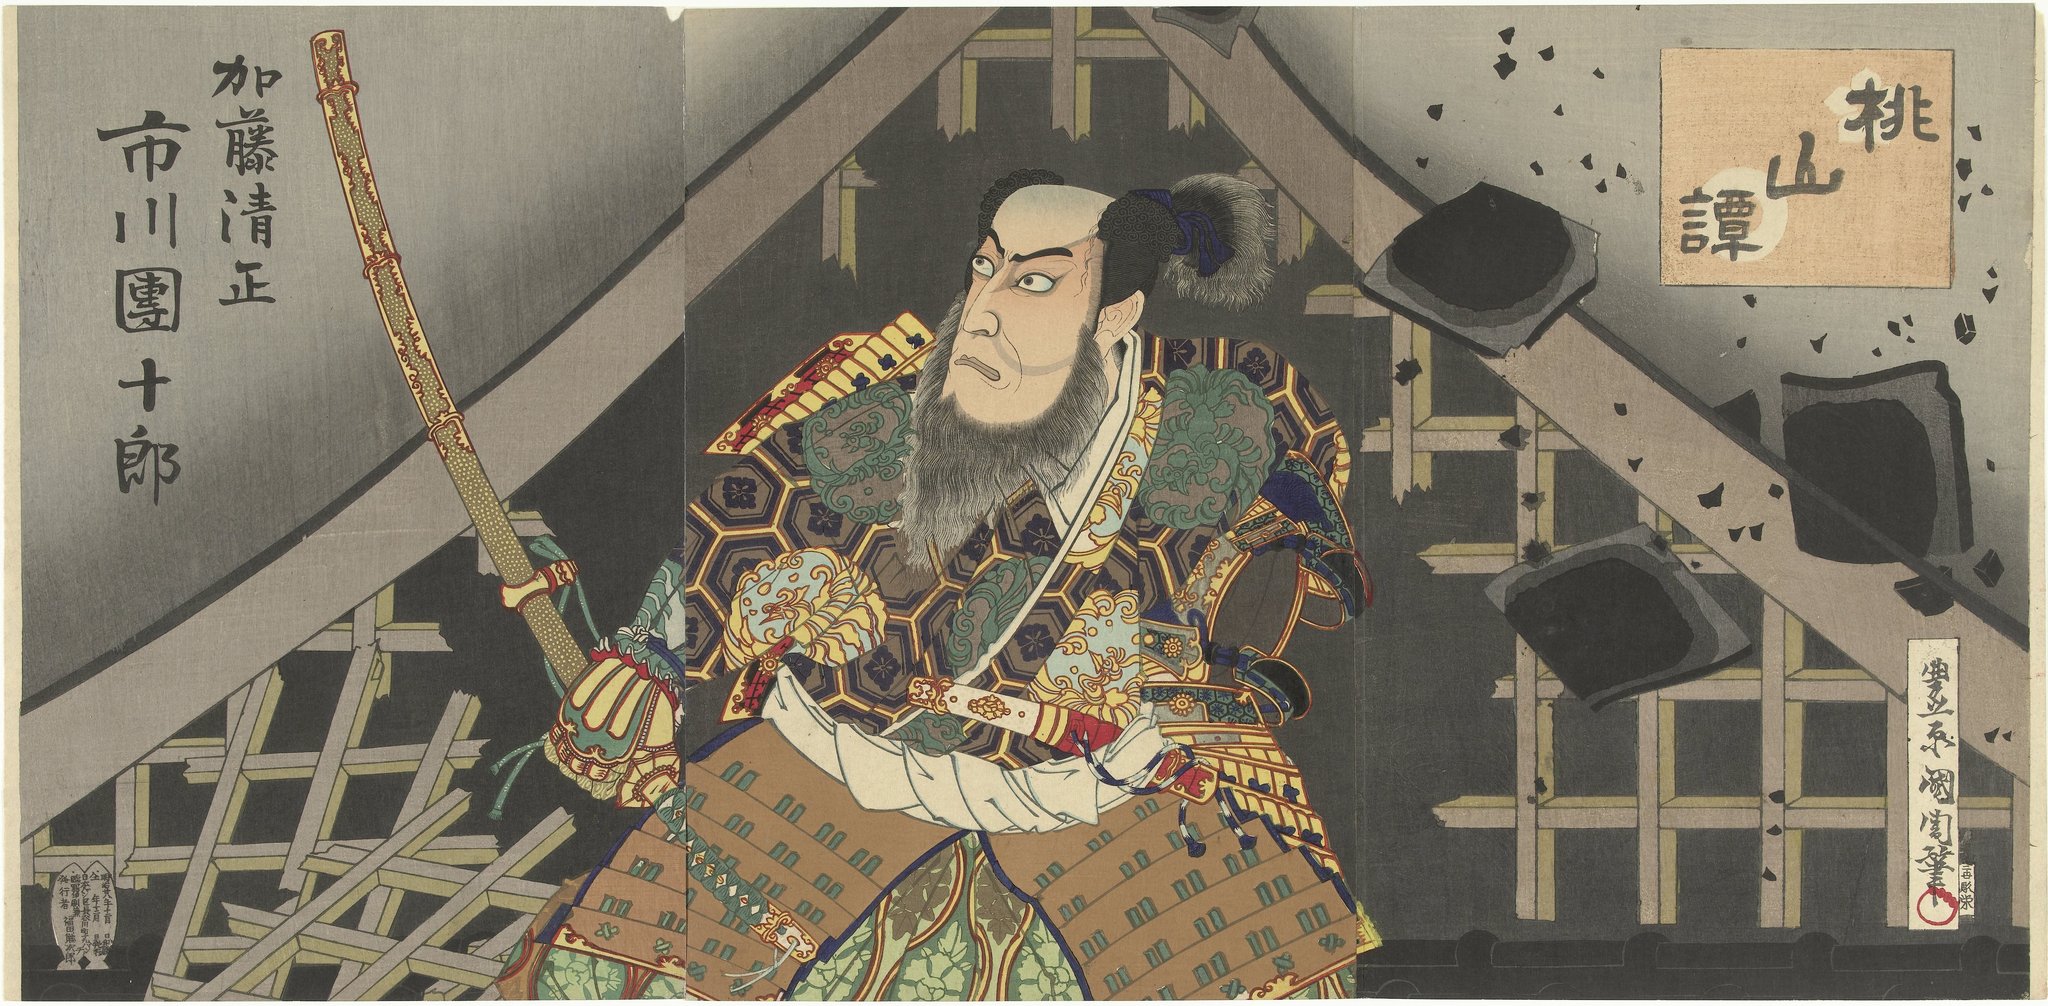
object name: print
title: Kato Kiyomasa Ichikawa Danjuro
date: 1812-1895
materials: paper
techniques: blind stamped, woodcut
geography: tokyo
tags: hacking and thrusting weapons: sword, portrait of actor, actress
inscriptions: collector's mark: Lugt 2228, collector's mark: Lugt 2760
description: De acteur Ichikawa Danjuro IX in de rol van generaal Kato Kiyomasa, met zwaard in rechter hand, staand bij vallende brokstukken en een verwoest raamwerk; scene uit het toneelstuk Momoyama no dan (het Momoyama verhaal).